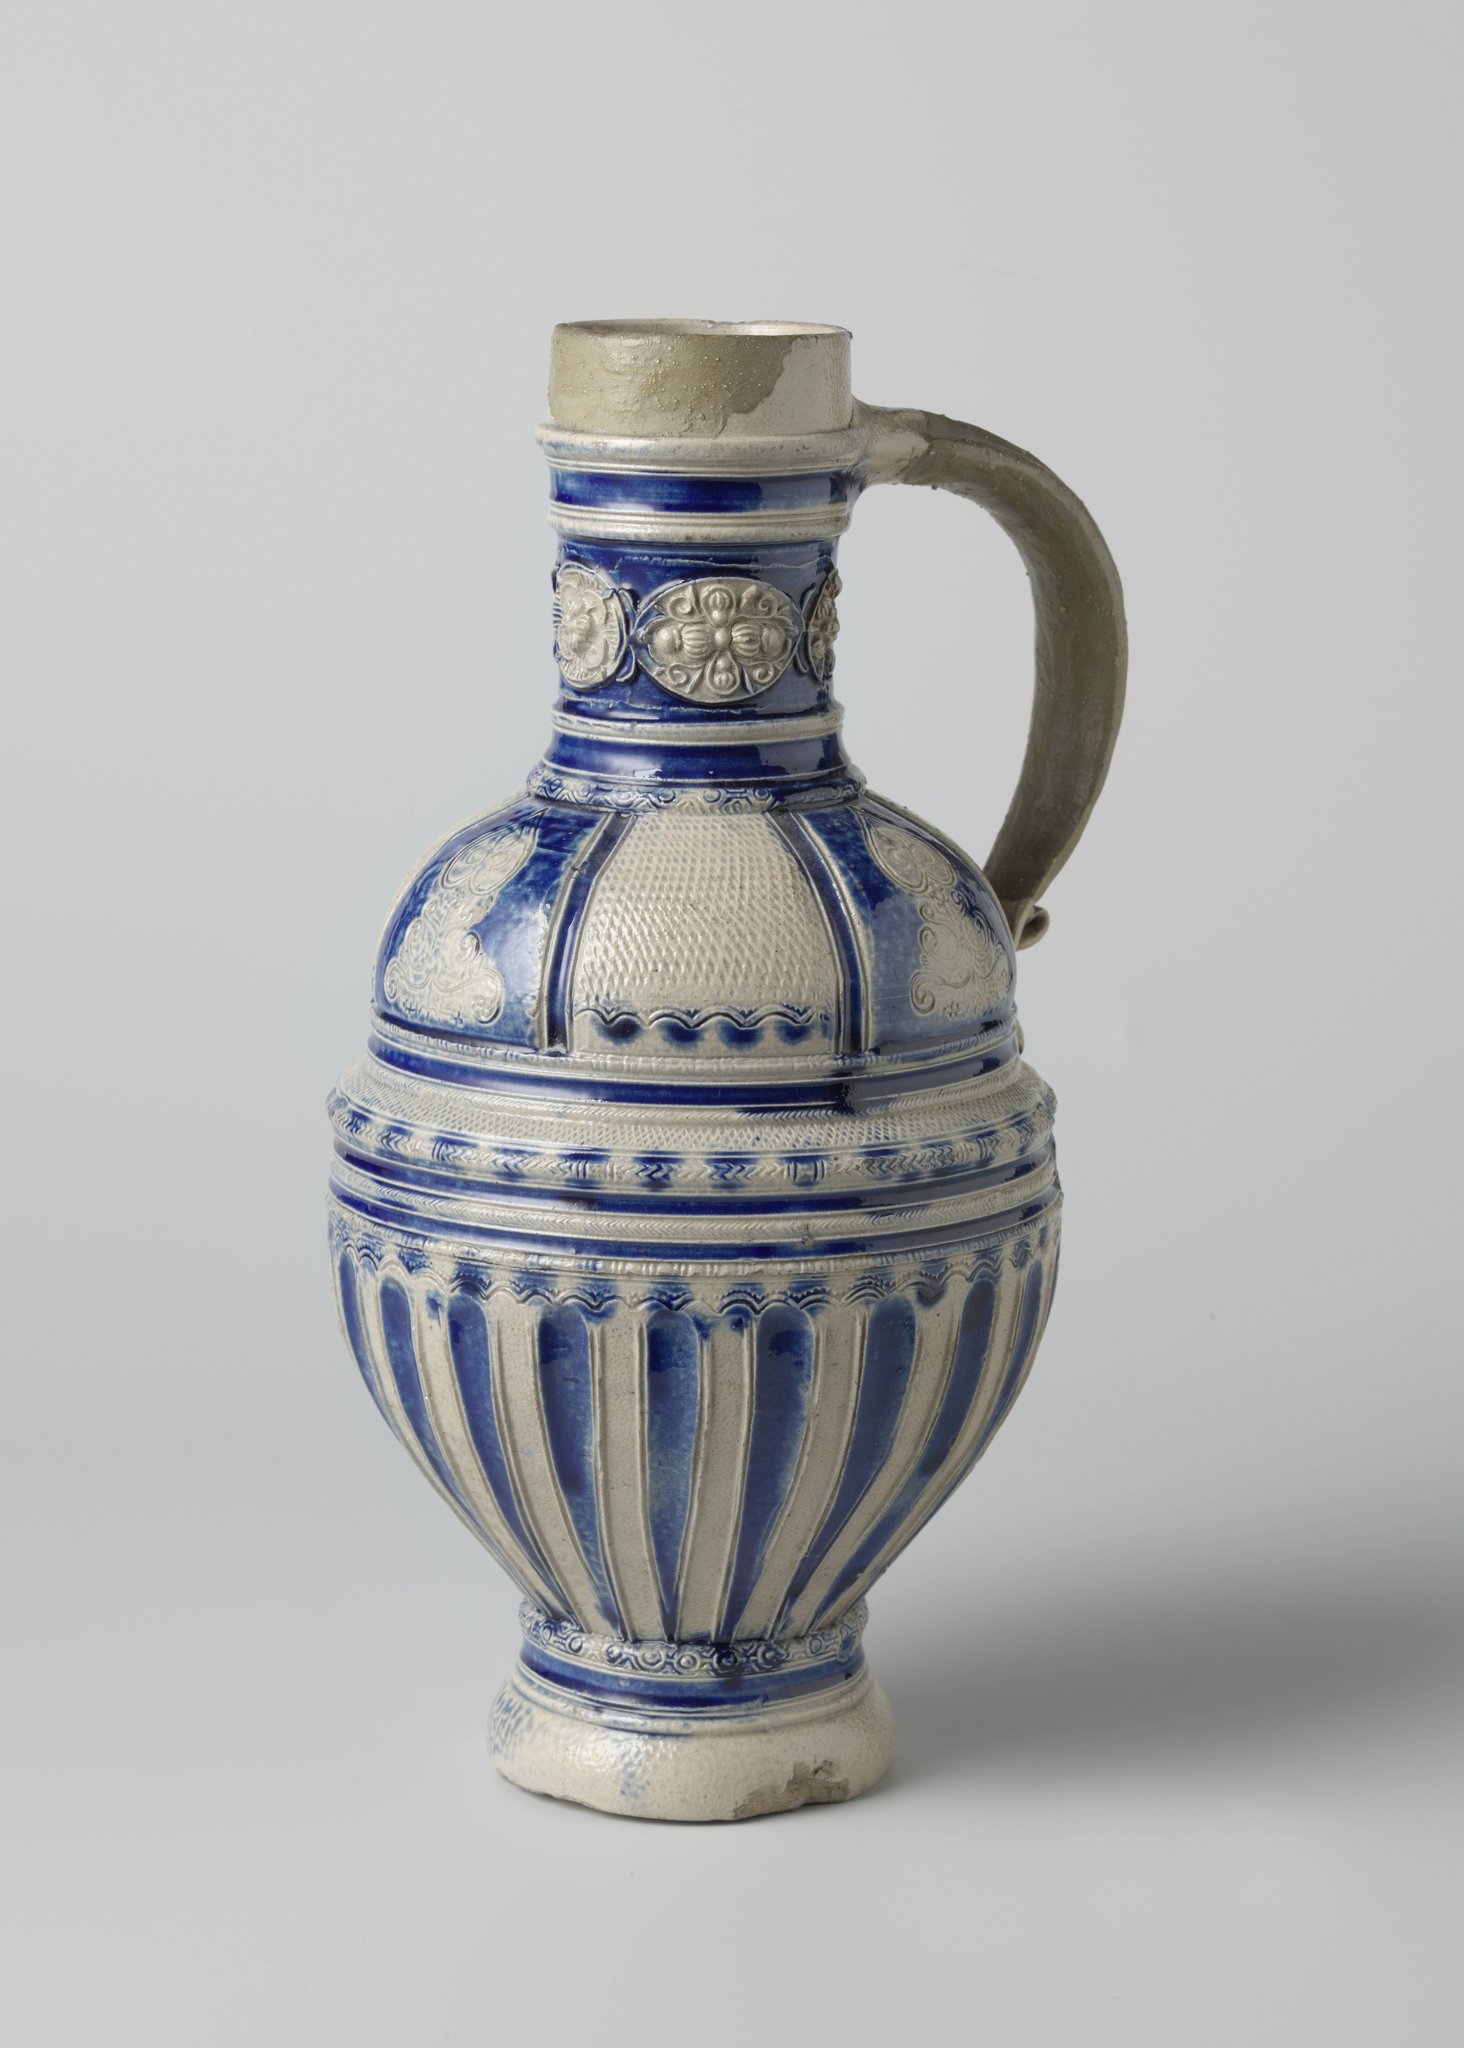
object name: jug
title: Jug with scrolls, chip carving and roundels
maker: Anonymous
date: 1550-1649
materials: cobalt, glaze, stoneware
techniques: printing, firing, forming, relief, turning, vitrification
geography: raeren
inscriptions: mark: ‘E’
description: Kruik van steengoed op hoge voet met een bolvormig lichaam en wijde nek. Het C-vormige oor is bevestig aan de nek en de schouder. Profielen op de nek, buik en voet. Gedeeltelijk bedekt met kobaltblauw. Het onderste deel van de buik met canelures. Een brede band profielen met decoratieve banden scheidt de buik van de iets smallere schouder. Op de schouder vakken met afwisselend kerfsnede en gestempeld krulwerk onder een fleur-de-lis in een hart, uitgespaard in blauw. Op de nek in reliëf een gedrukte en opgelegde band met afwisselend ronde en ovale medaillons met een rozet. De bovenzijde van het oor is gemerkt met een gestempelde 'E'. Raeren.